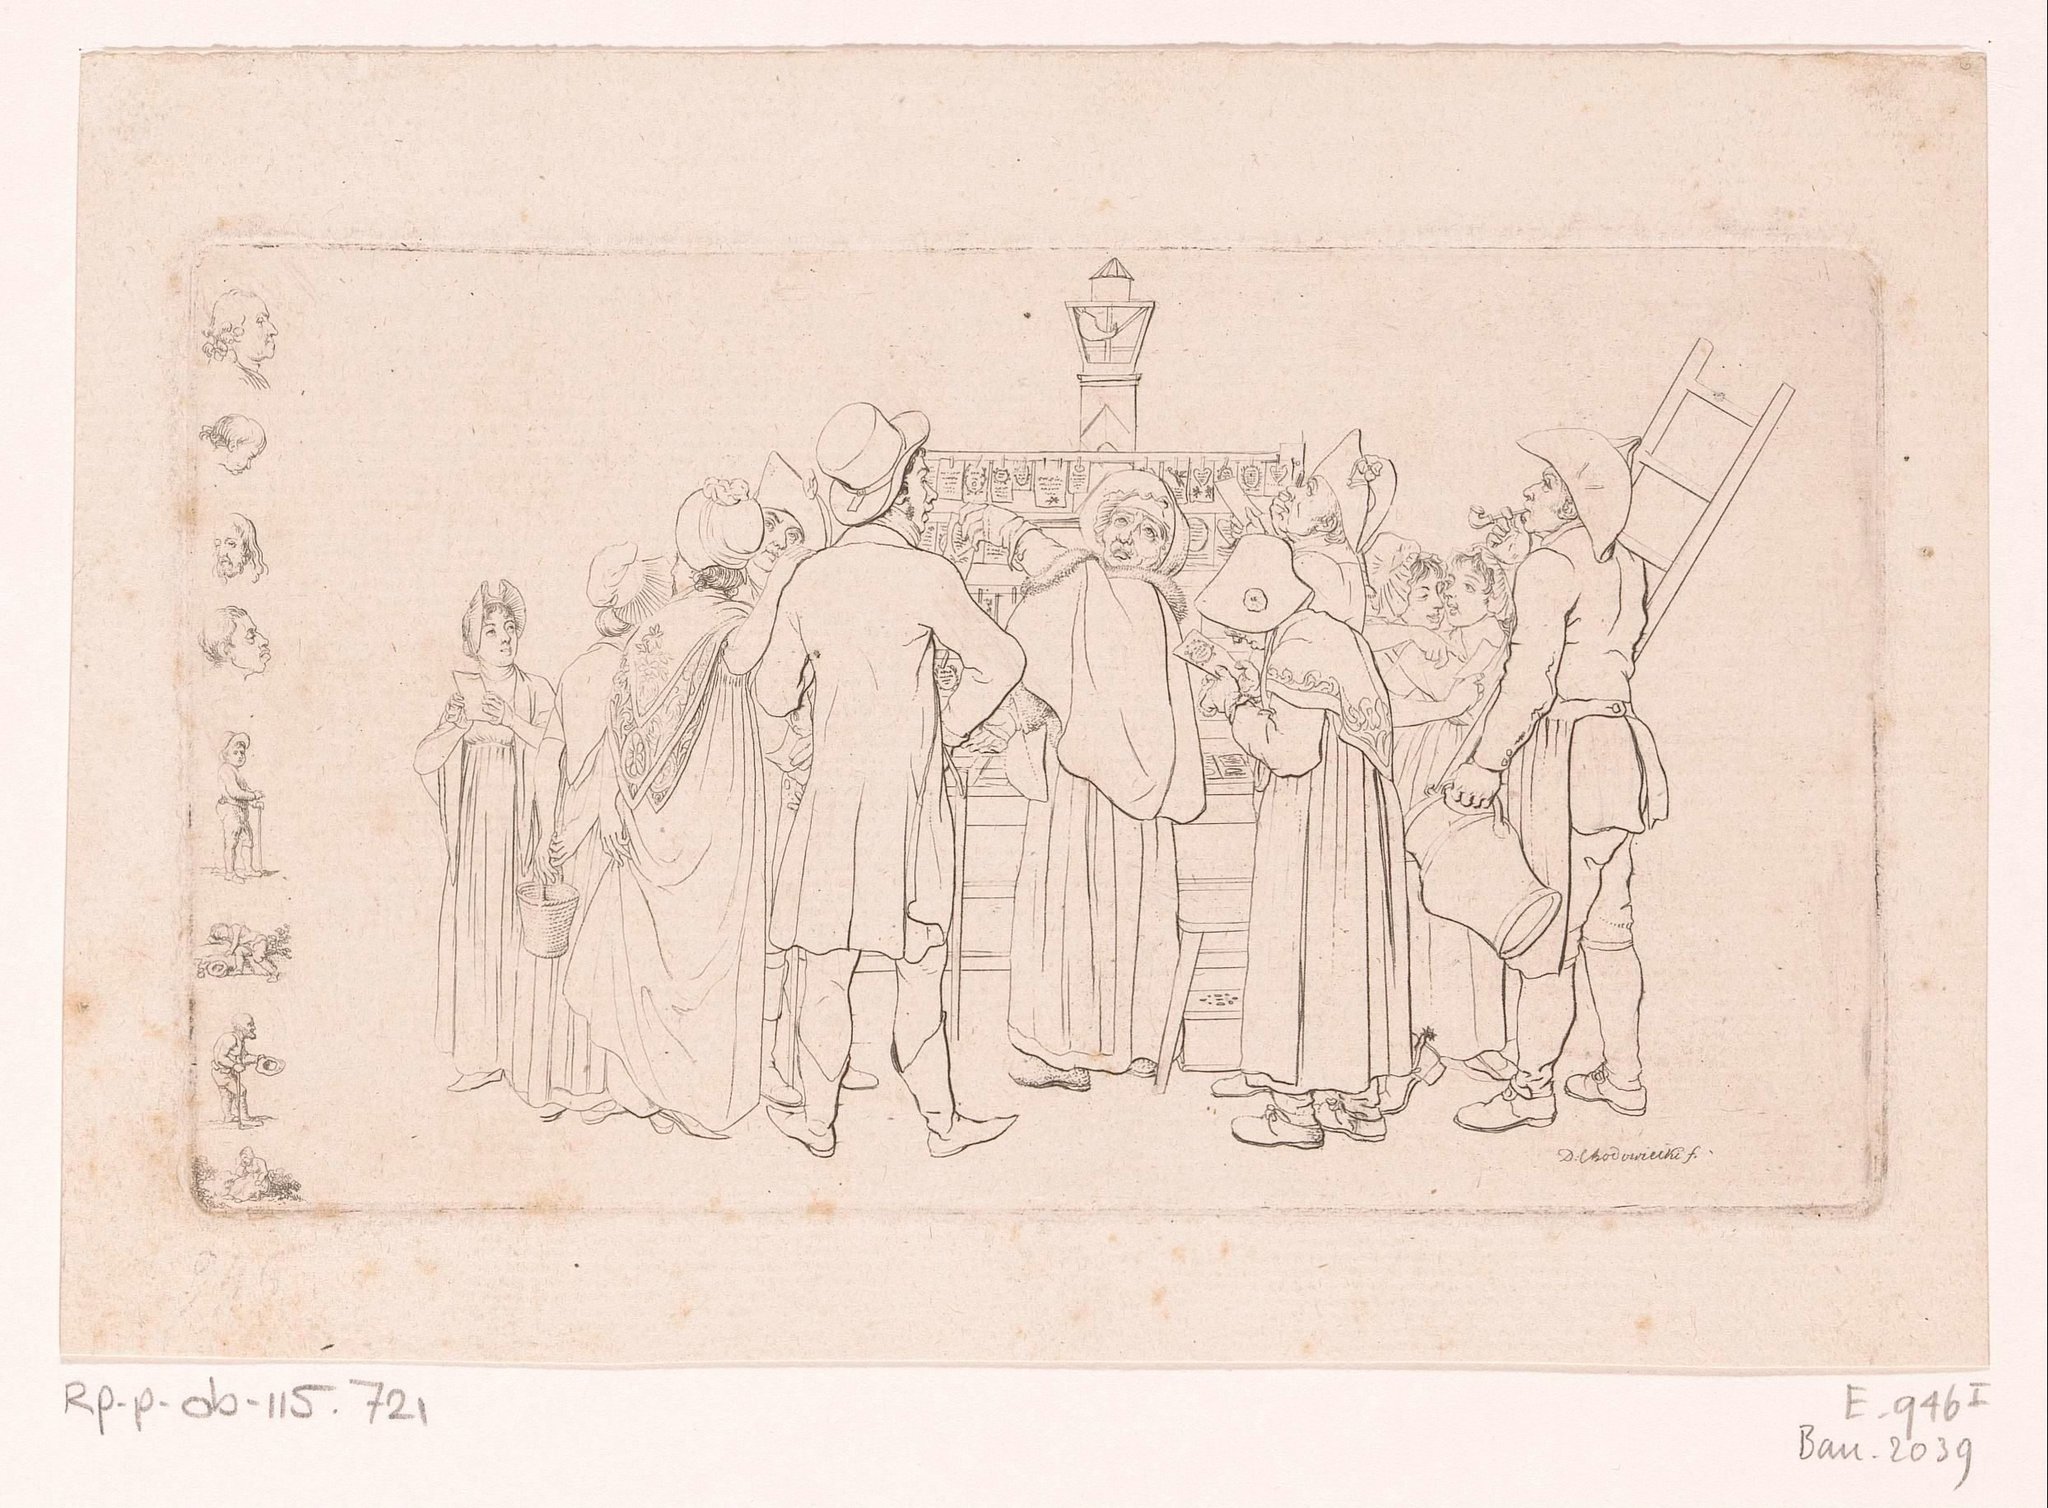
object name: print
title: Nieuwjaarskaartenverkoopster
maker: daniel nikolaus chodowiecki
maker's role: draughtsman, print maker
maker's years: 1726-1801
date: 1800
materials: paper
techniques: etching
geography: berlin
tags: christmas card, stall, booth (~ market), merchant, salesman - bb - women engaged in trade and commerce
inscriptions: collector's mark: Lugt 2228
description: Links in de marge zijn op schetsmatige wijze verschillende koppen en figuren geëtst.